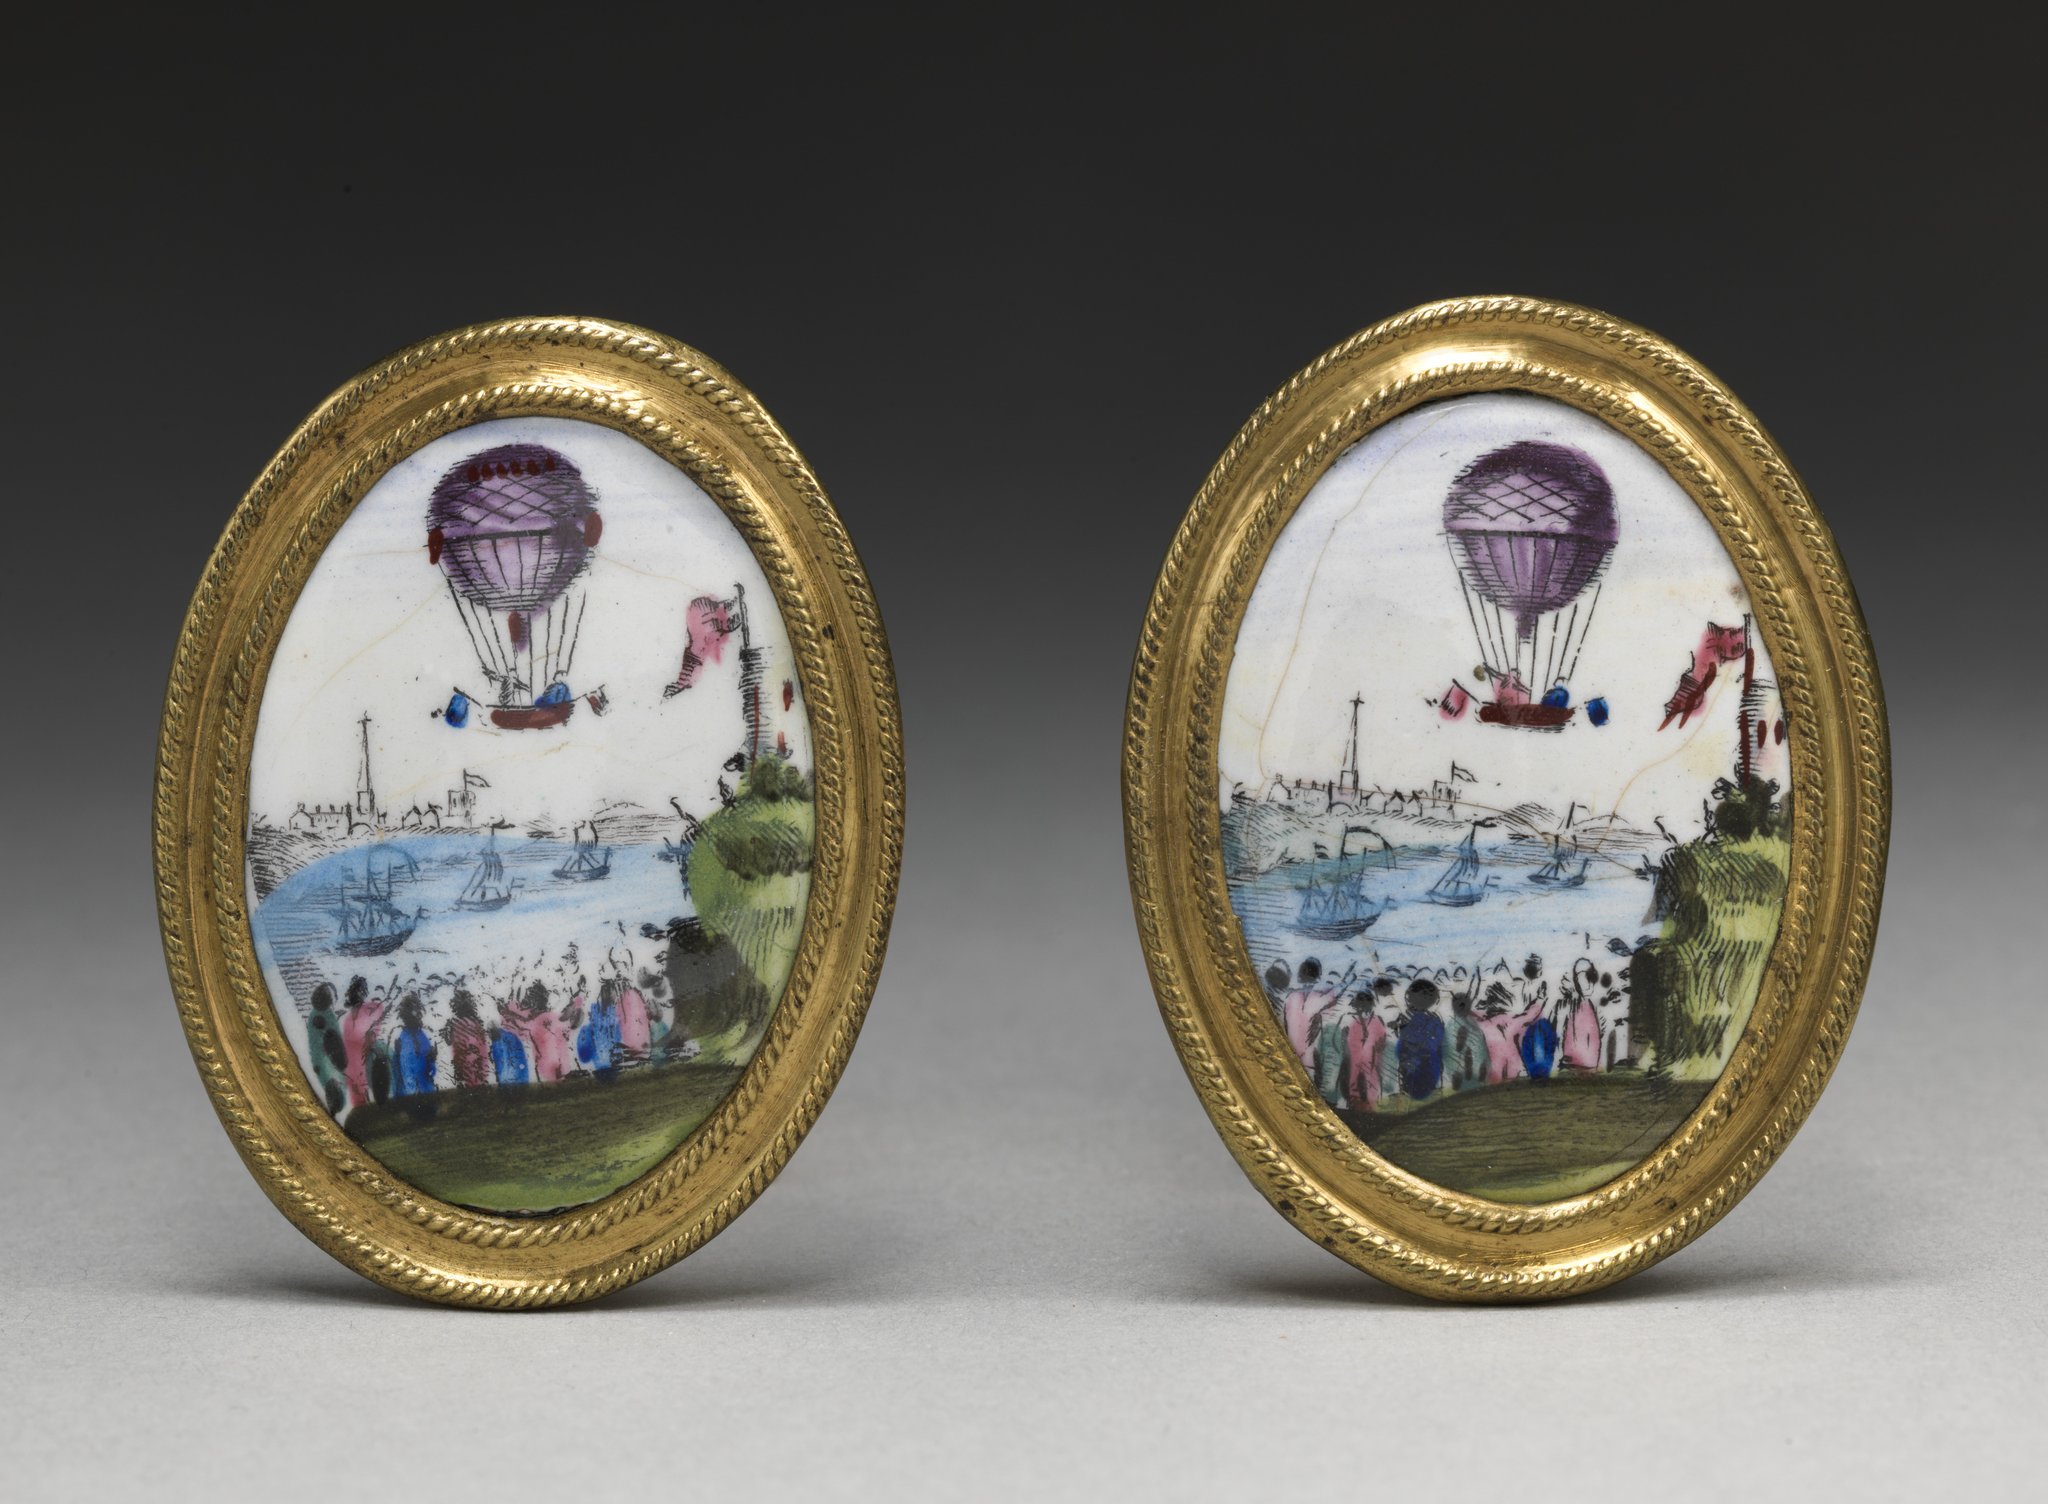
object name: knob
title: Pair of knobs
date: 1783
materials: brass, copper, enamel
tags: hot air balloons,ships